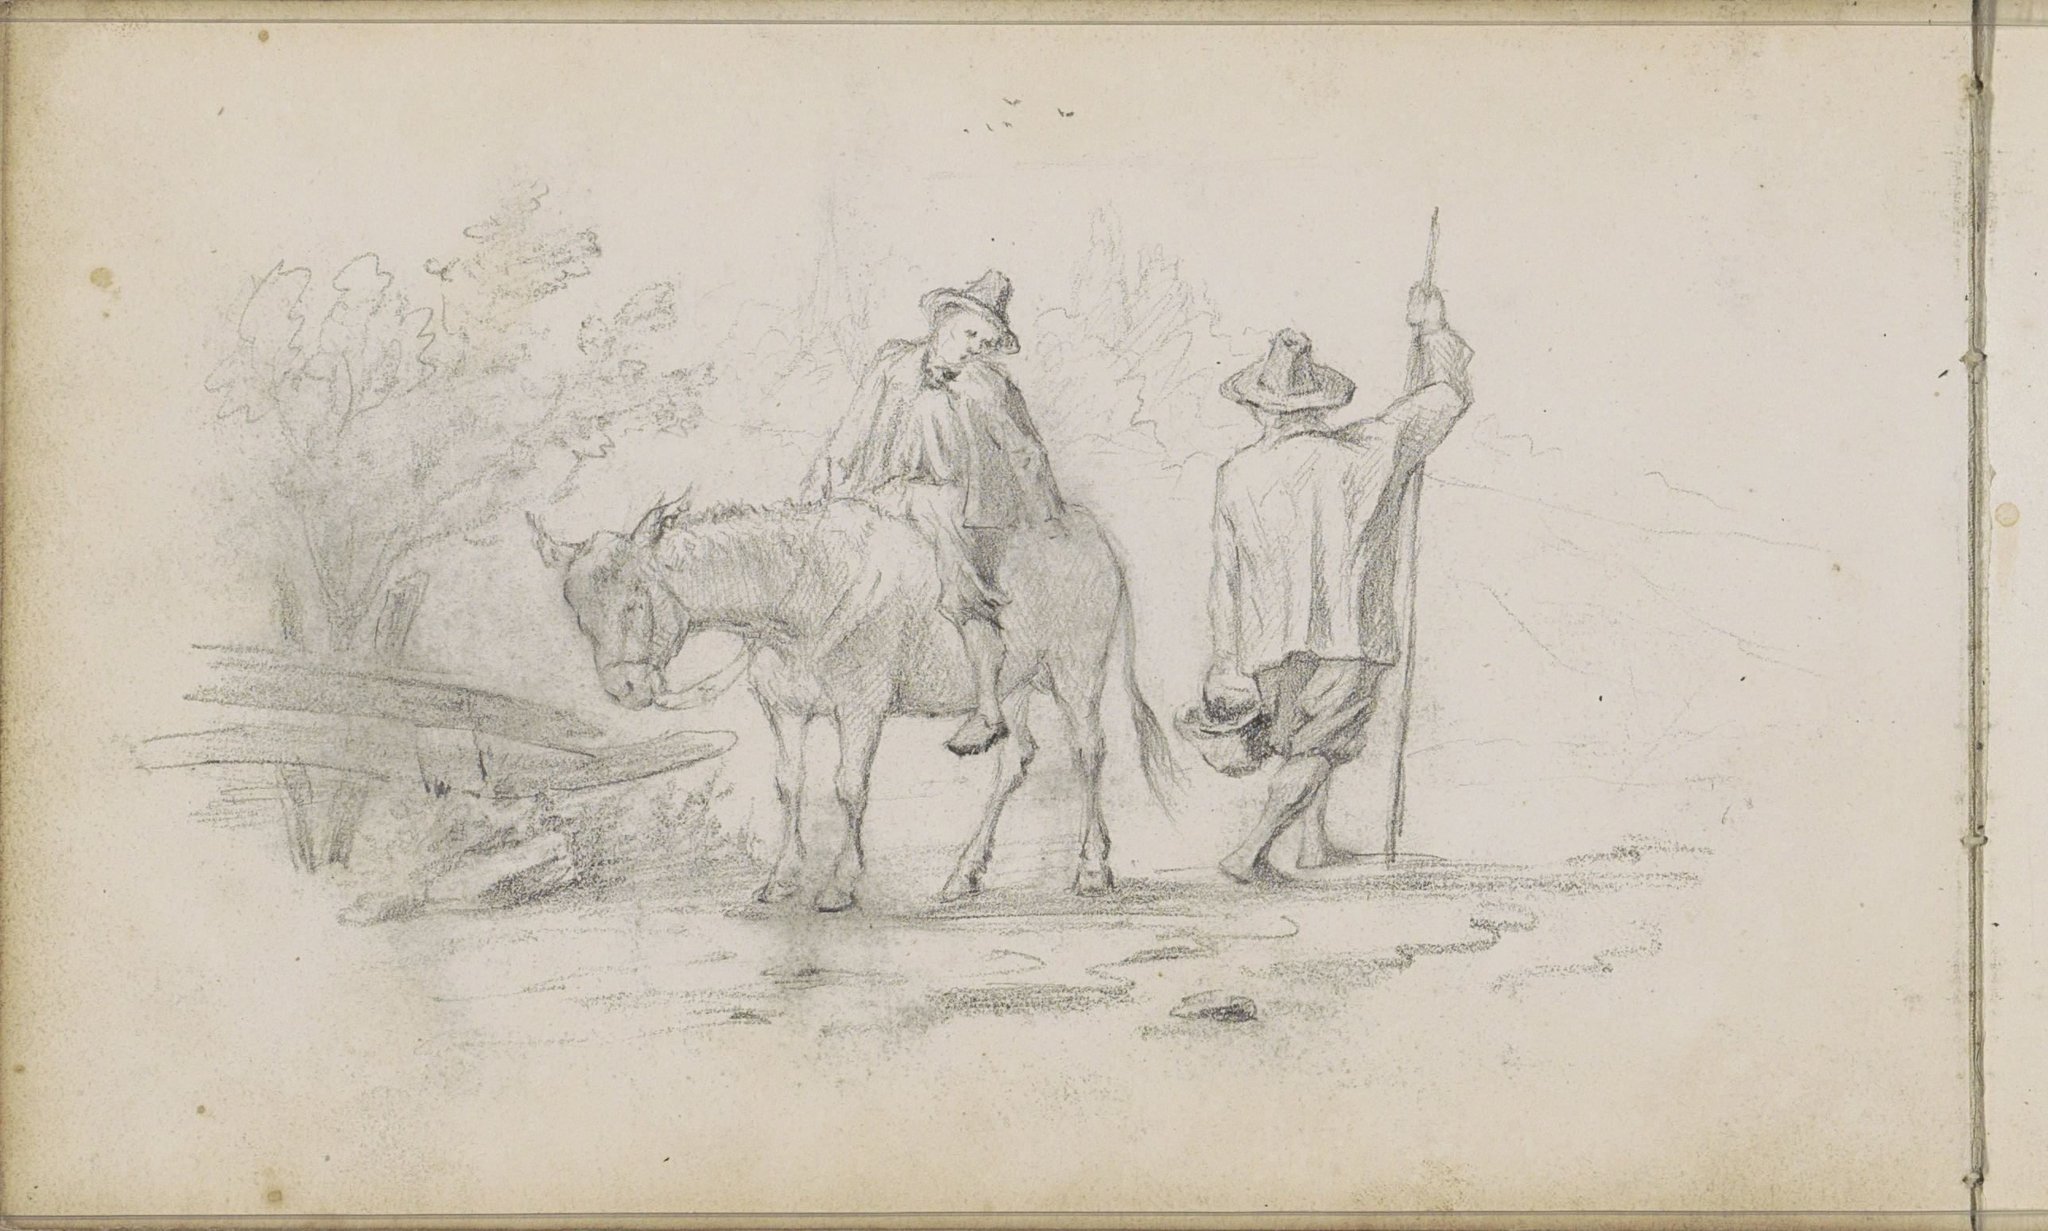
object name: sketchbook leaf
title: Wandelaar en een man op een ezel die elkaar kruisen op een pad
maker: willem cornelis rip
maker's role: draughtsman, painter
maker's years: 1856-1922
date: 1874-1875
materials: paper, pencil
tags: riding a horse, ass, or mule; rider, horseman, road, path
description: Blad 22 verso uit een schetsboek met 46 bladen.